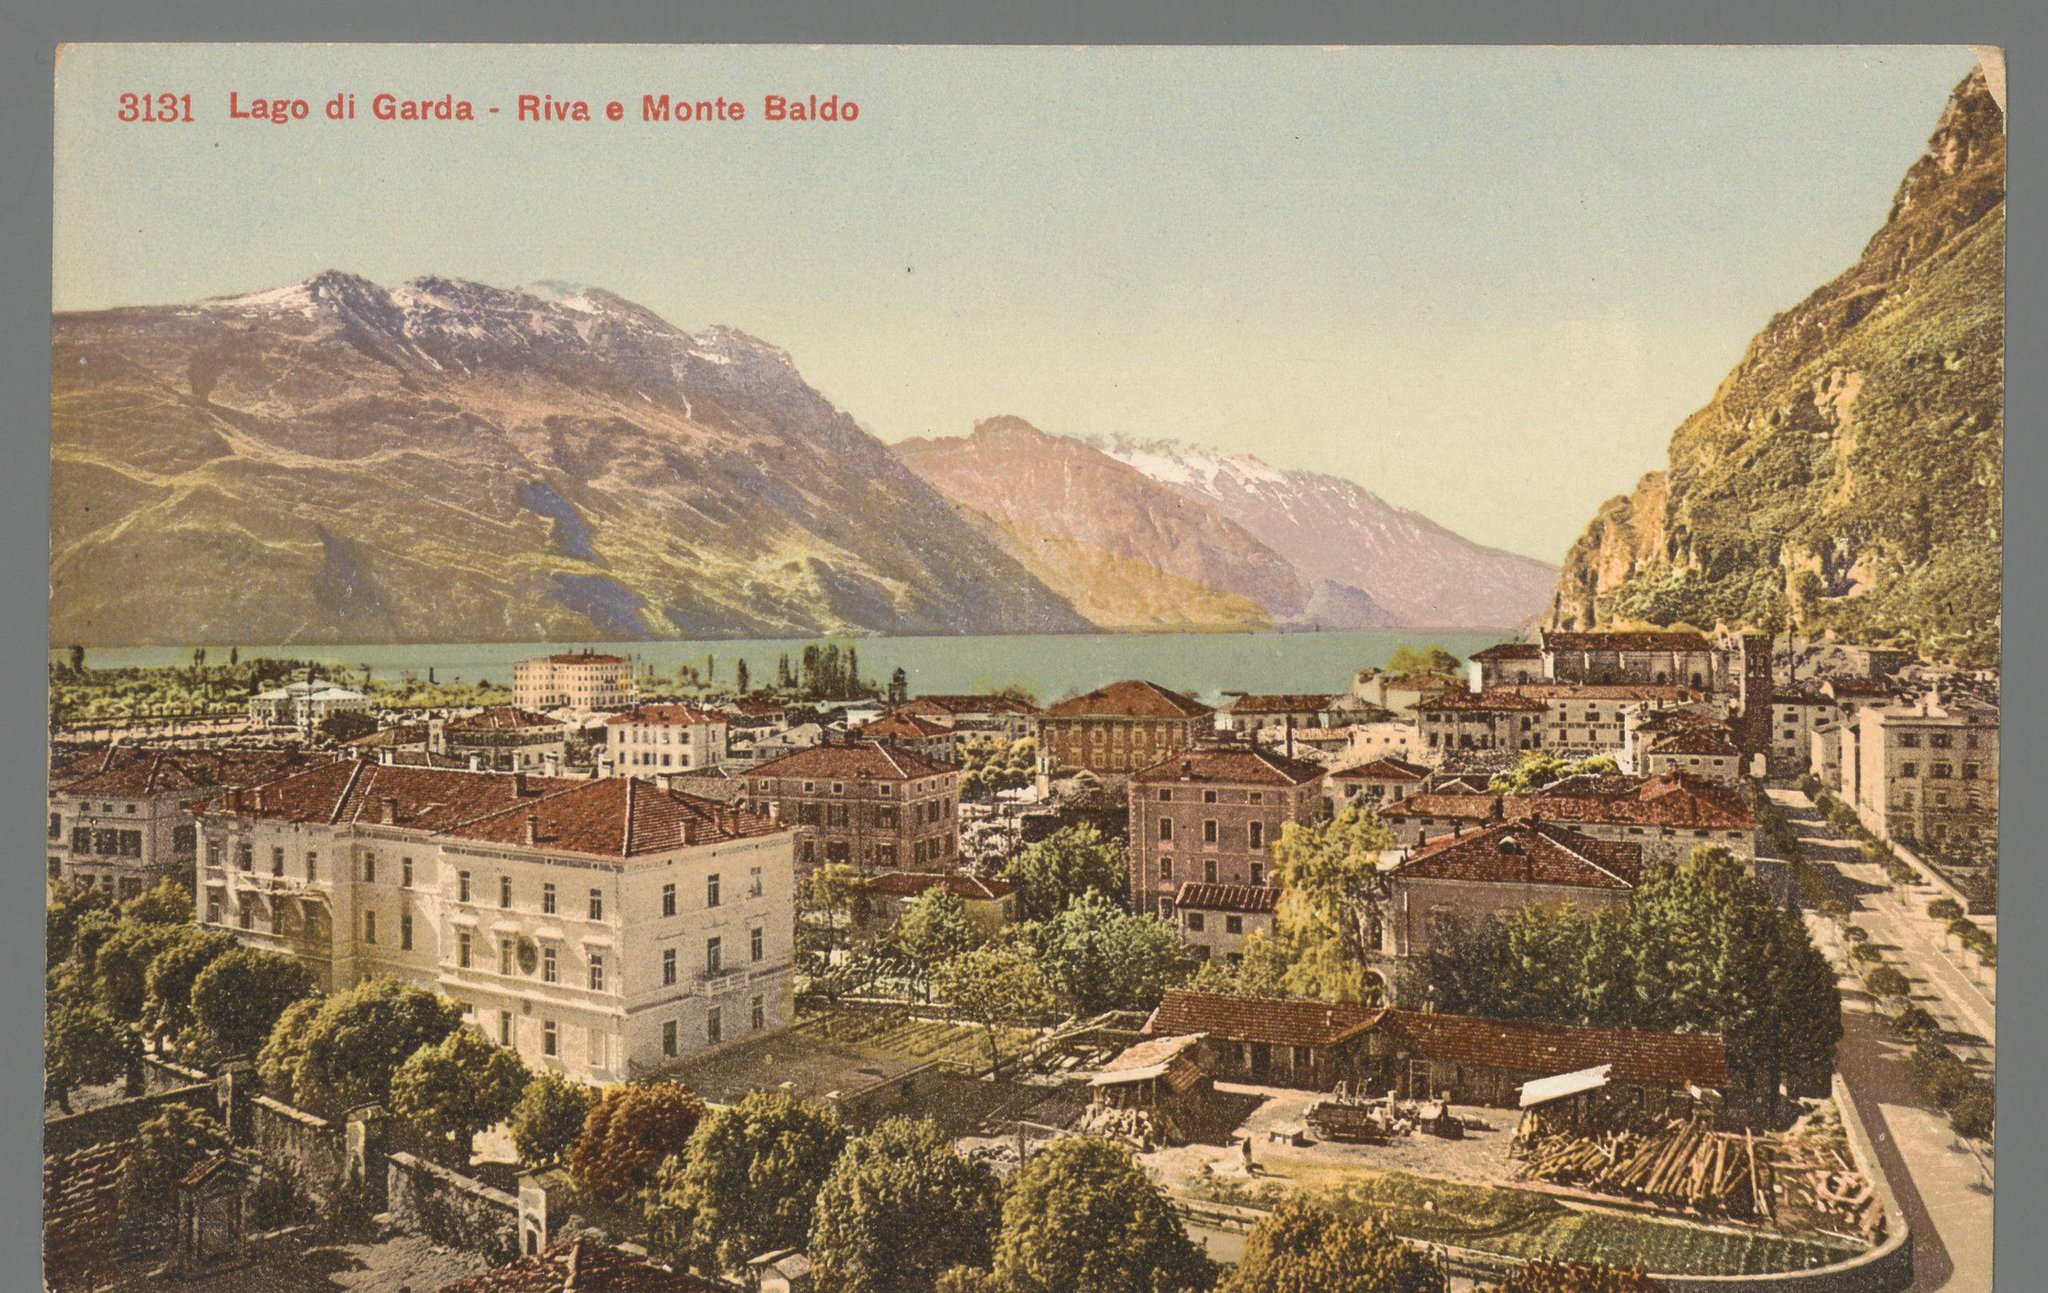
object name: photomechanical print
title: Lago di Garda. Riva e Monte Baldo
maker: Anonymous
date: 1905-1930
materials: cardboard, photographic process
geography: zurich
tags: lake, prospect of city, town panorama, silhouette of city, mountains